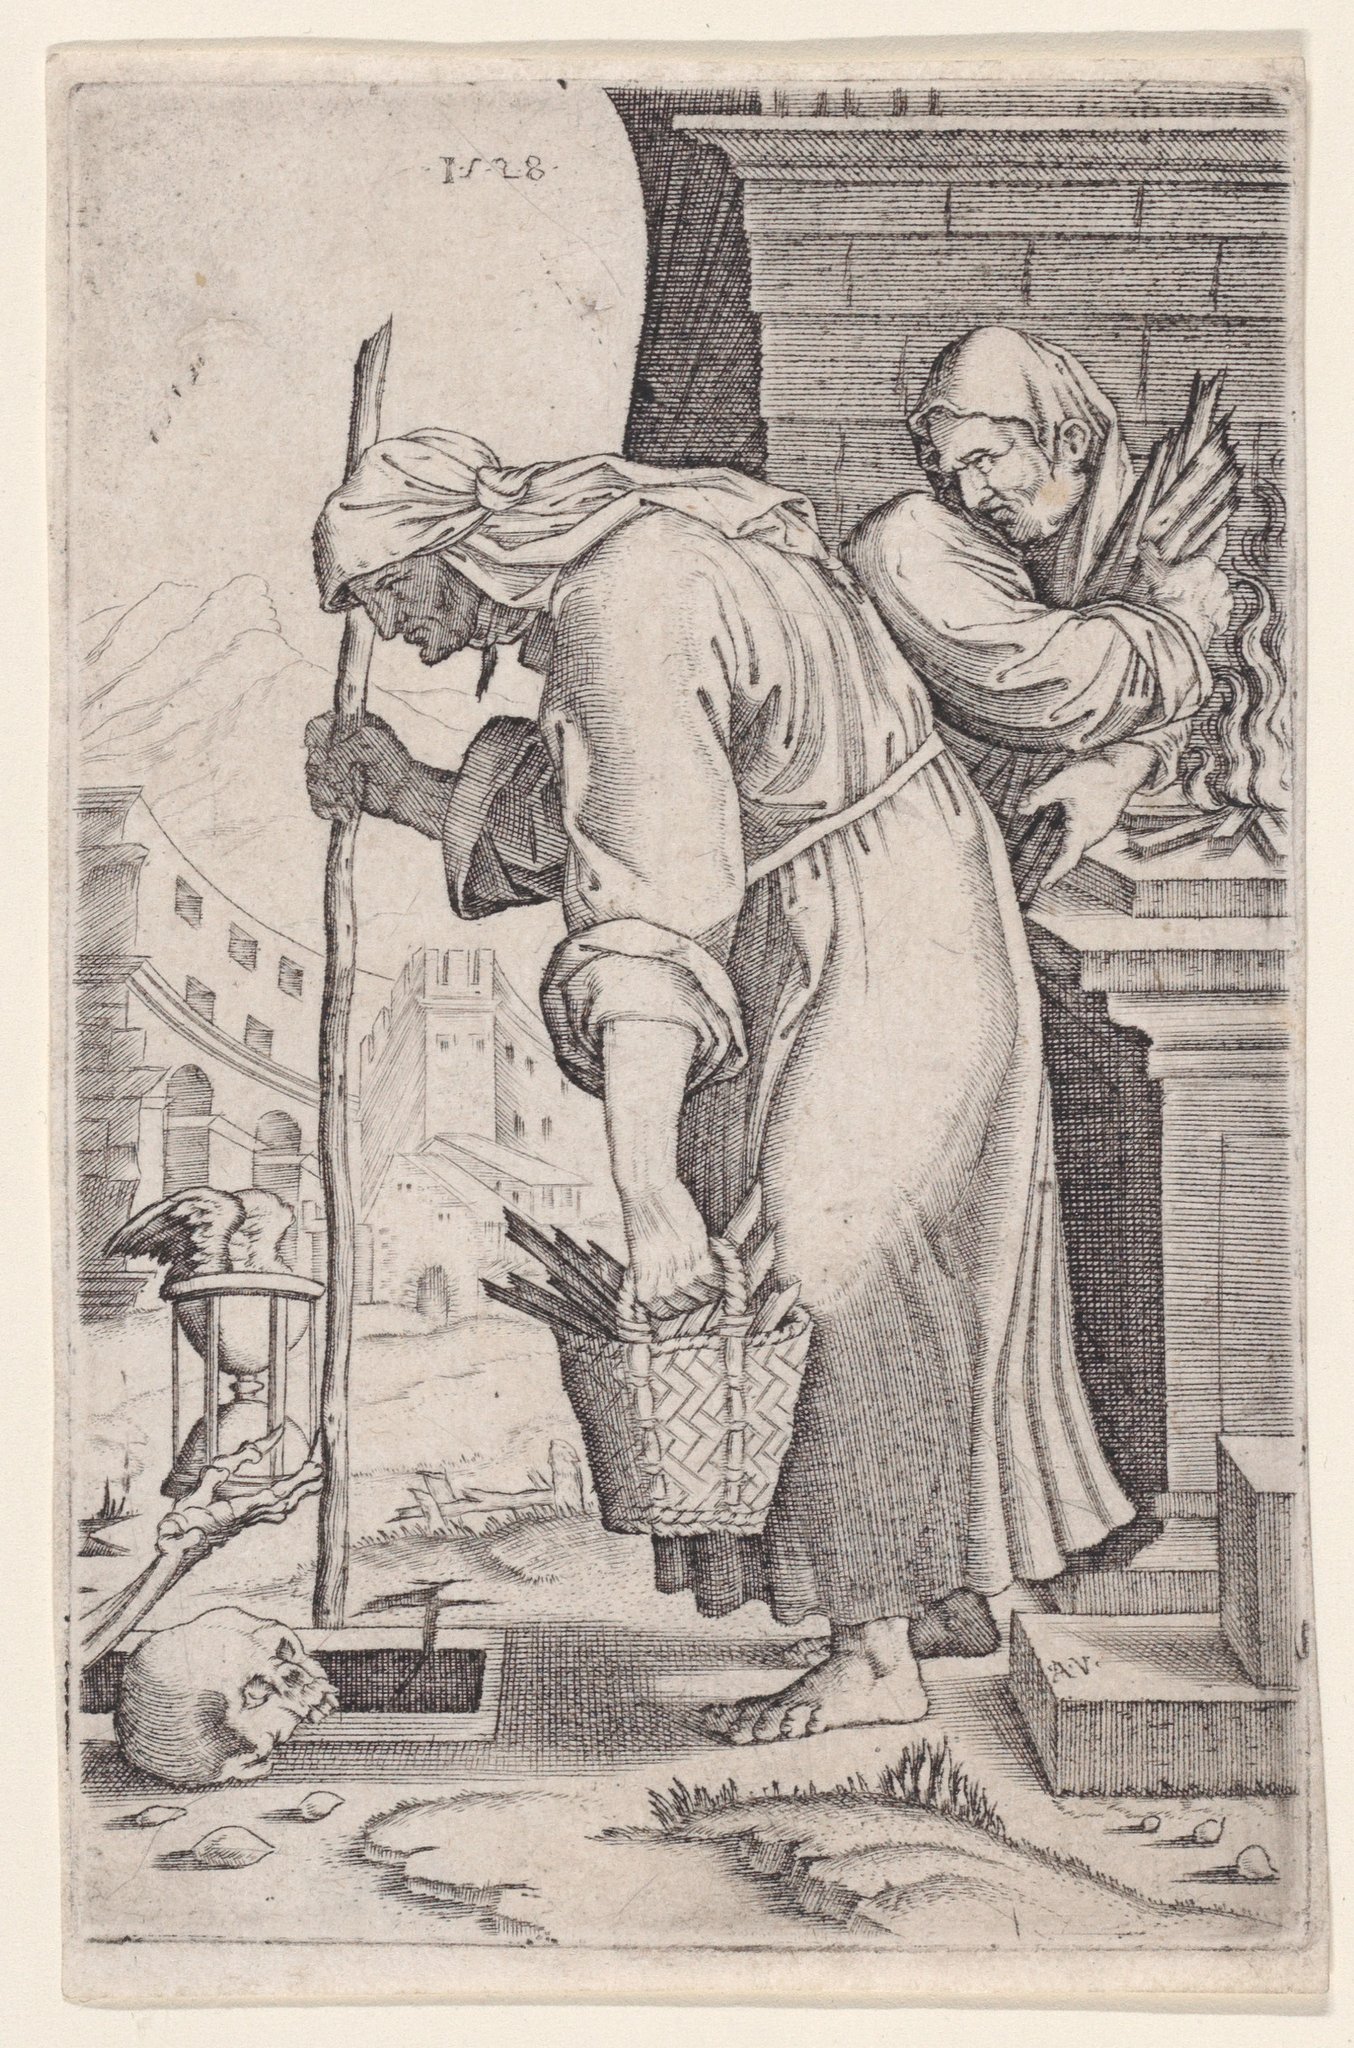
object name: print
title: Old Woman Approaching the Grave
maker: agostino veneziano (agostino dei musi)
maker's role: artist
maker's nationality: italian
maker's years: 1490-1536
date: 1528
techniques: engraving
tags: skulls,women